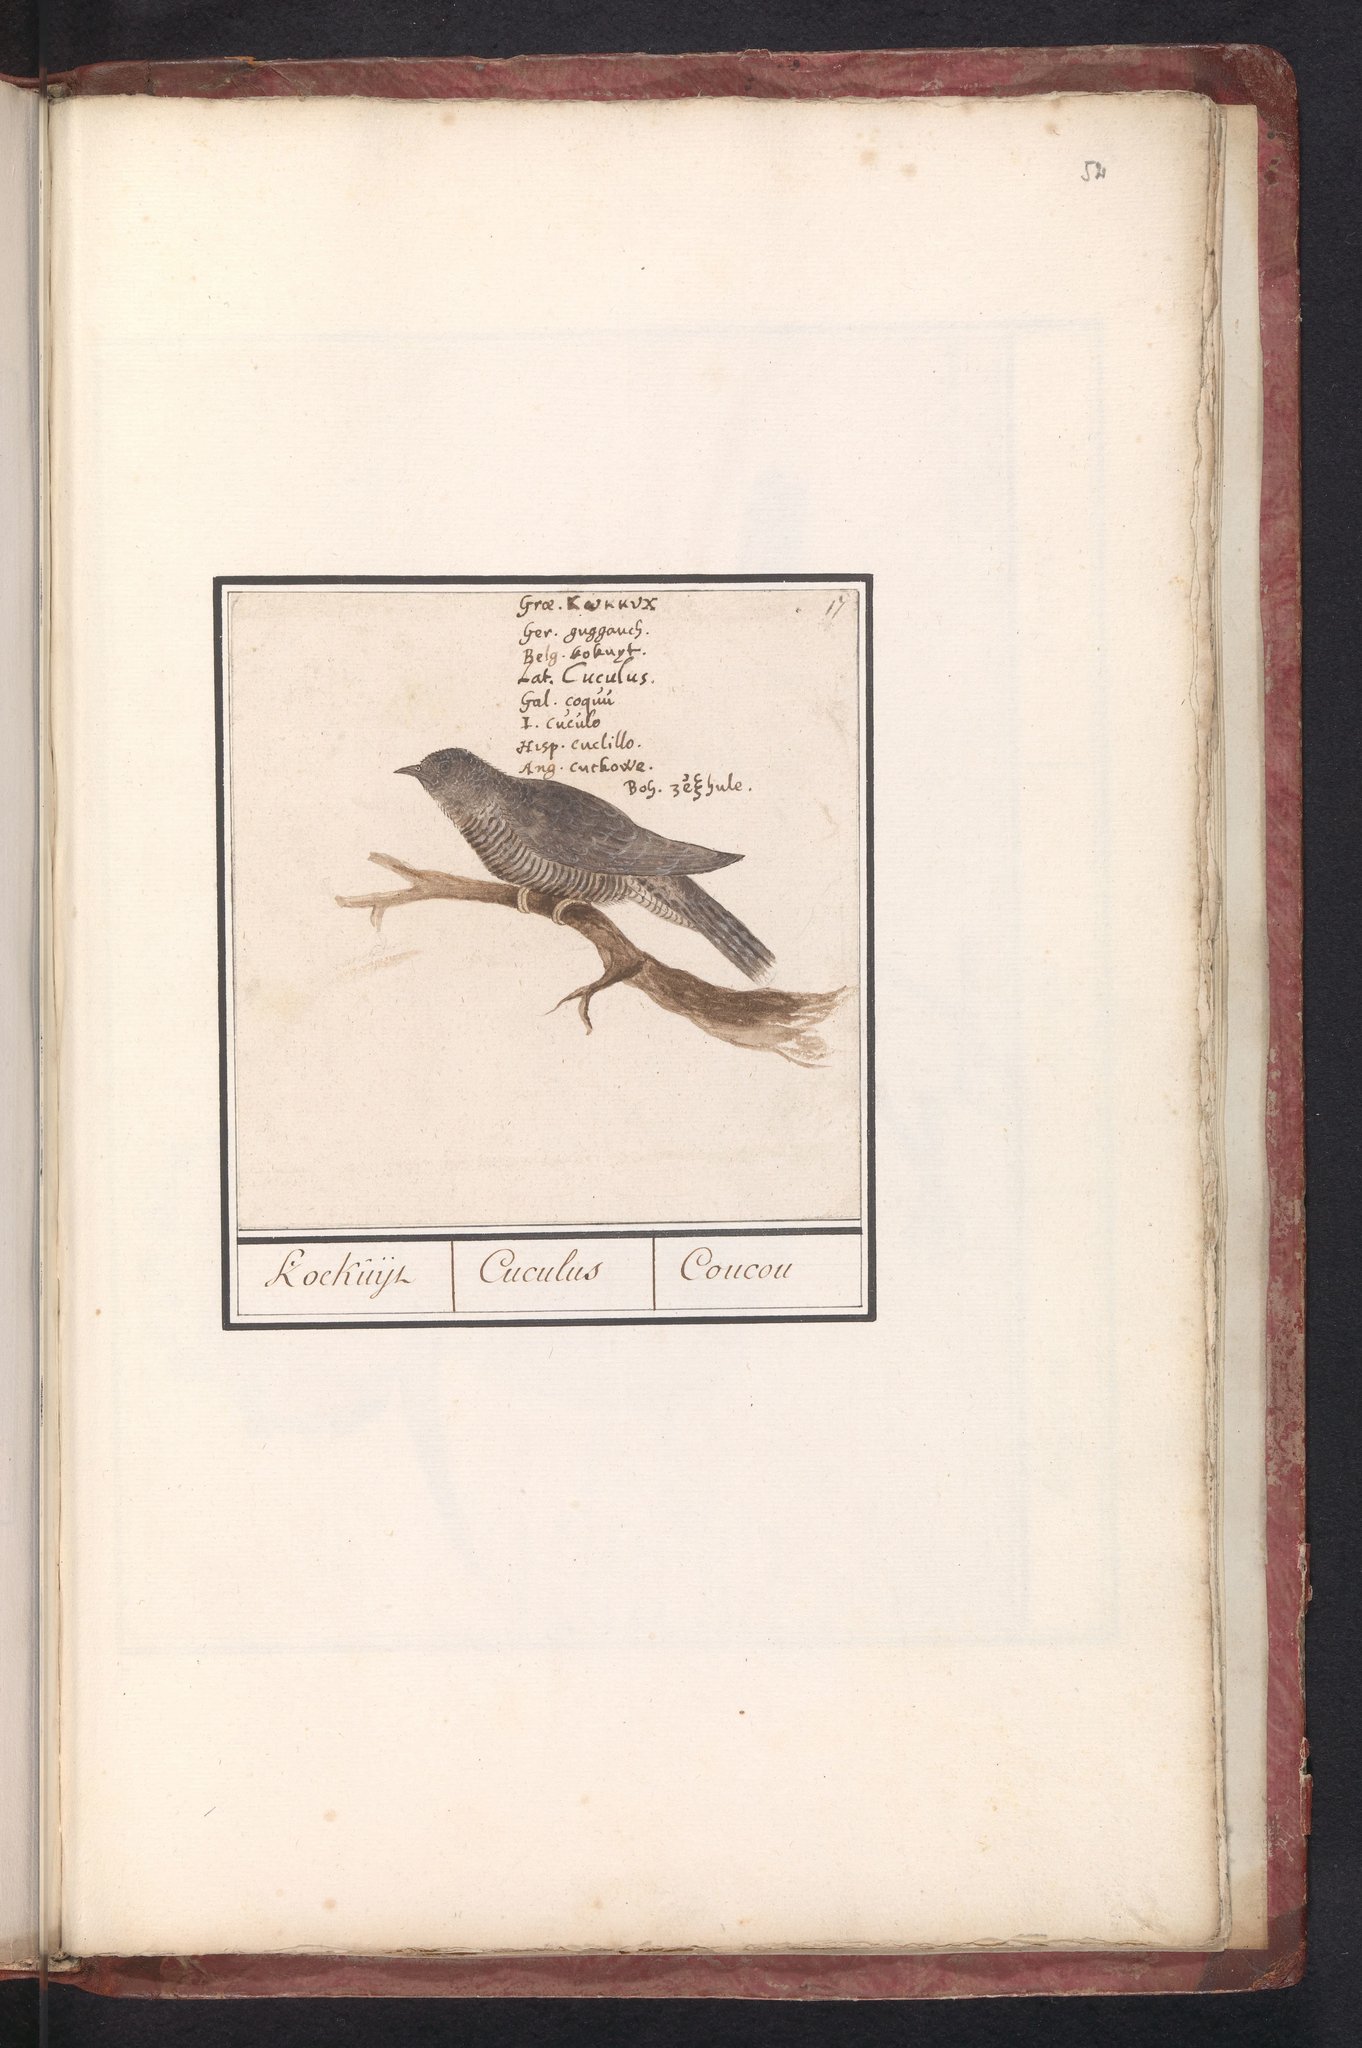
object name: drawing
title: Koekoek (Cuculus canorus)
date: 1596-1610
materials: paint, ink, paper, pencil, watercolor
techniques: brush, pen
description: Koekoek. Genummerd rechtsboven: 17. Bovenaan de naam in negen talen. Onderdeel van het tweede album met tekeningen van vogels. Vierde van twaalf albums met tekeningen van dieren, vogels en planten bekend rond 1600, gemaakt in opdracht van keizer Rudolf II. Met toelichting in Nederlands, Latijn en Frans.